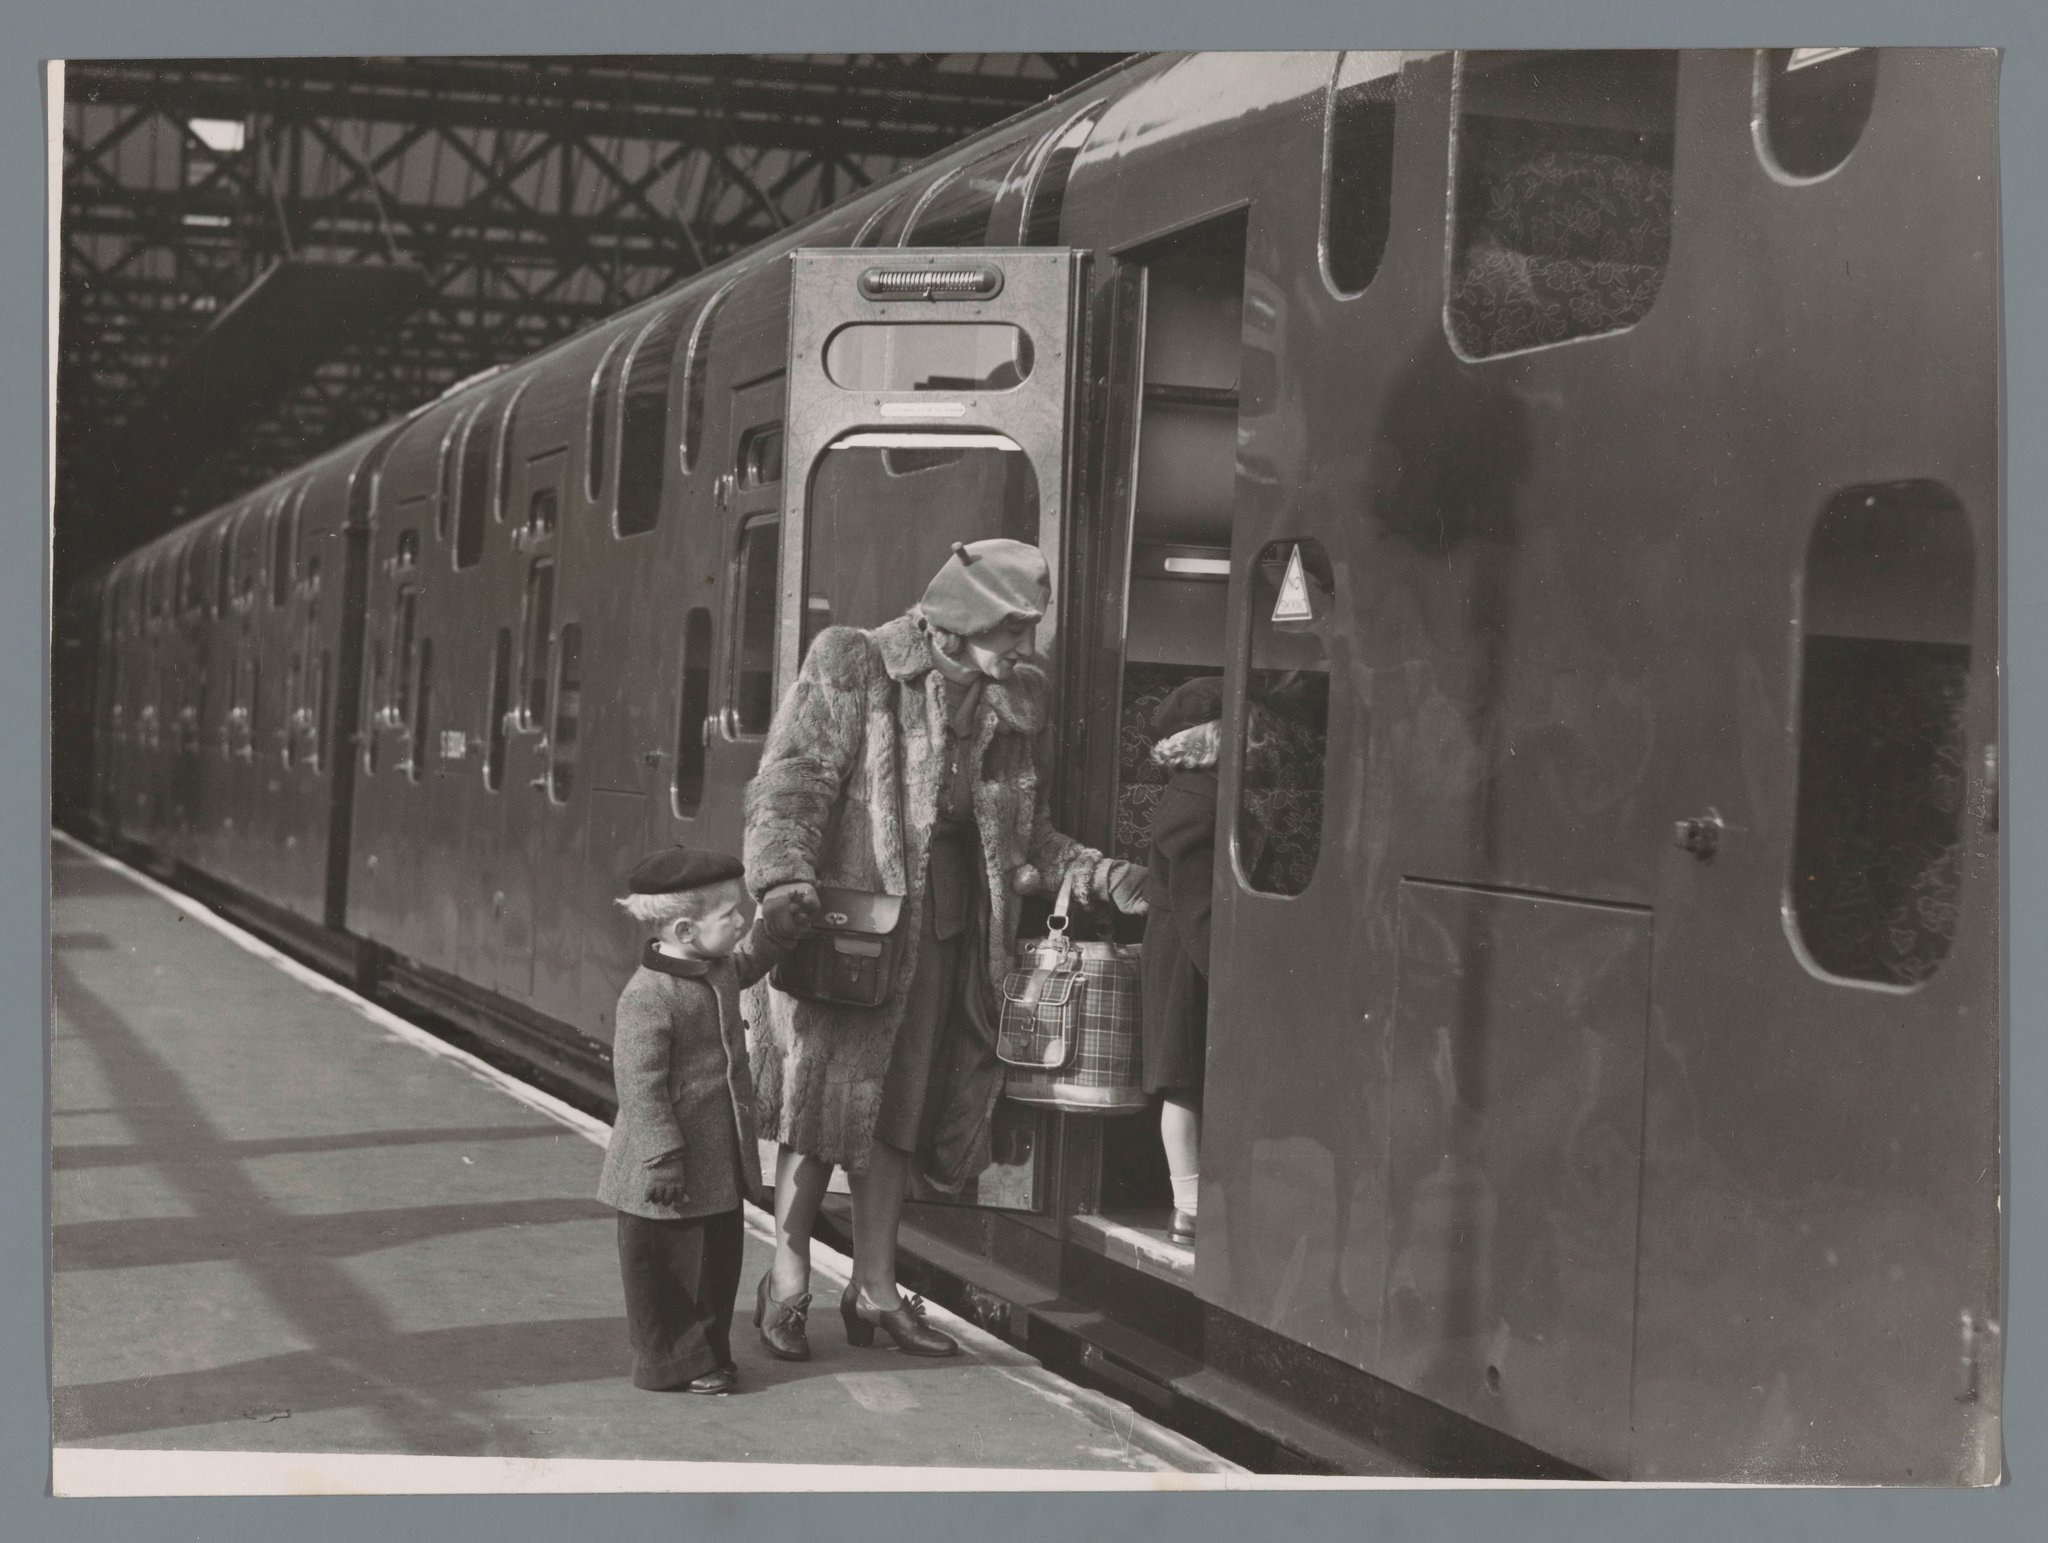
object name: photograph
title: Vrouw en twee kinderen stappen in een dubbeldekkertrein op Charing Cross Station te Londen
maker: r. palmer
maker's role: fotograaf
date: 1949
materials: photographic support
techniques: gelatin silver print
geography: charing cross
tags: passenger train, mother and child(ren), woman and child(ren) (family group)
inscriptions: inscription: ‘Copyright photo Press (...) Postaux 96.49’, inscription: ‘Special trip of British railways (...) International News Photo’